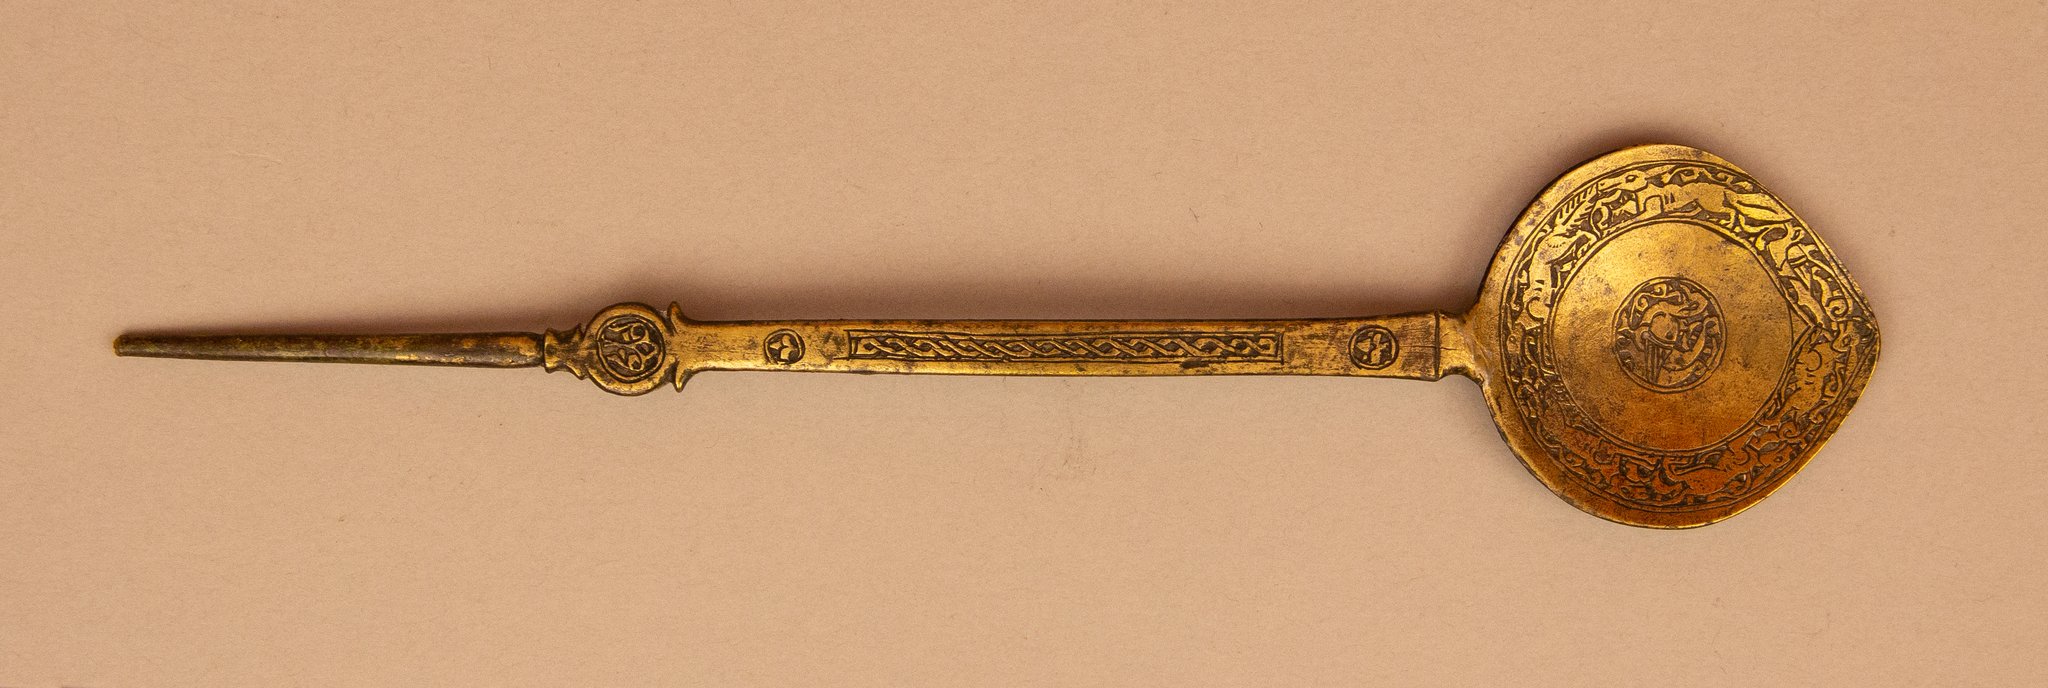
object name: spoon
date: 1101-1300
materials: brass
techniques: casting, engraving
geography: iran